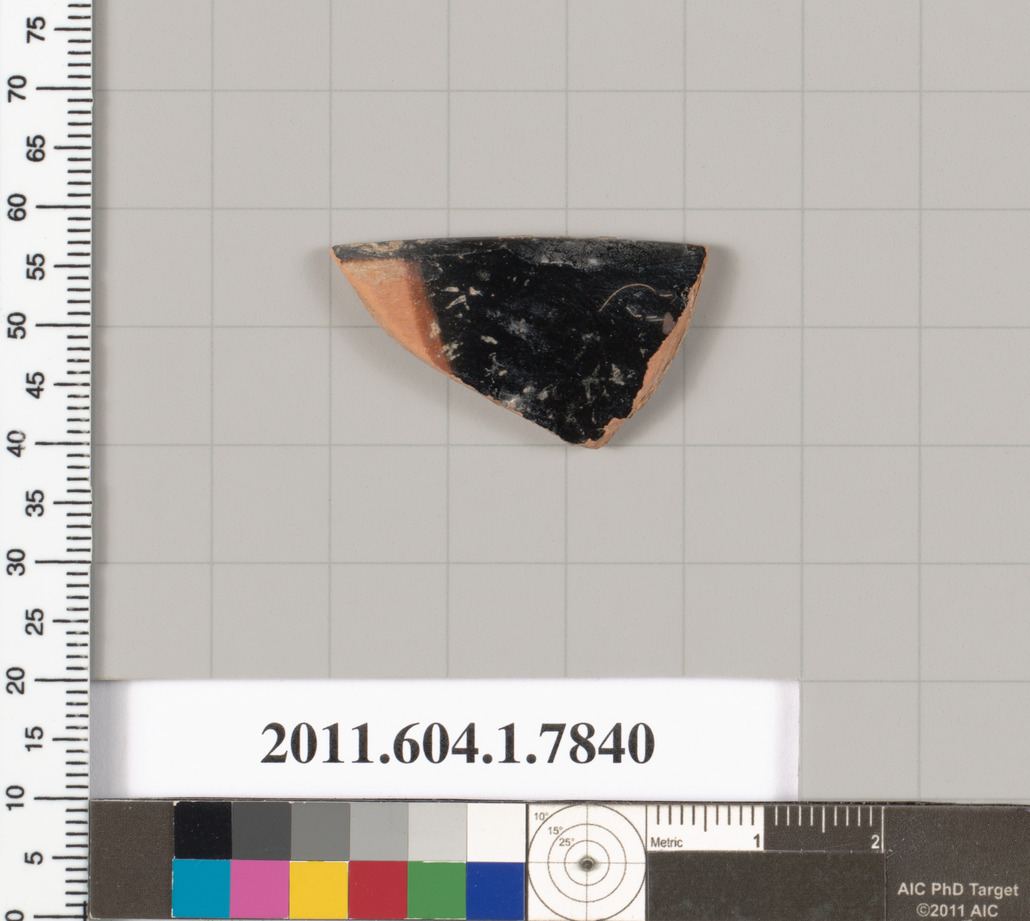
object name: kylix fragment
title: Terracotta fragment of a kylix (drinking cup)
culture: greek, attic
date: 460-450 BCE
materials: terracotta